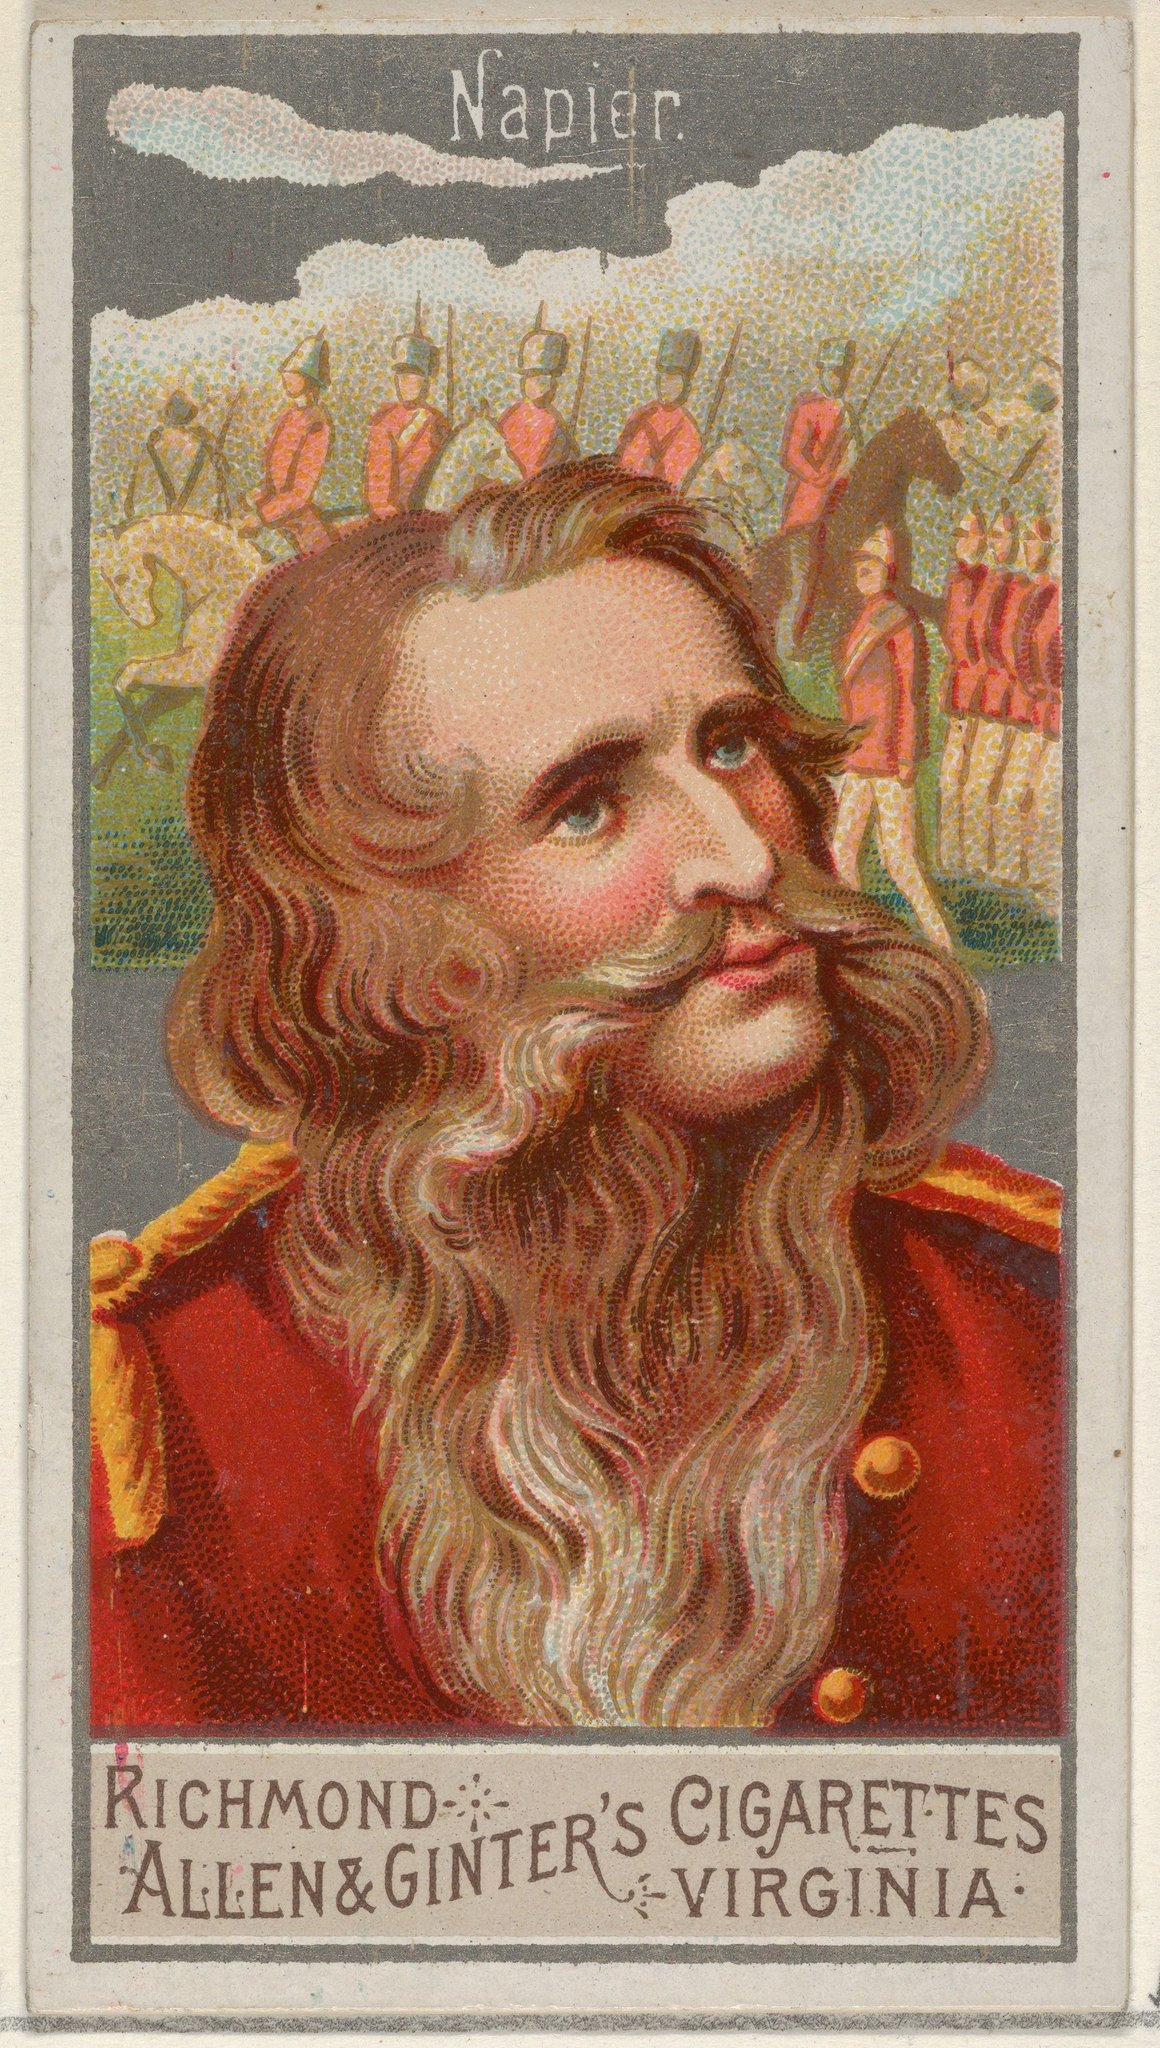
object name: print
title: Napier, from the Great Generals series (N15) for Allen & Ginter Cigarettes Brands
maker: allen & ginter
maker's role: publisher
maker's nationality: american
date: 1888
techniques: color lithograph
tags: historical figures,men,generals